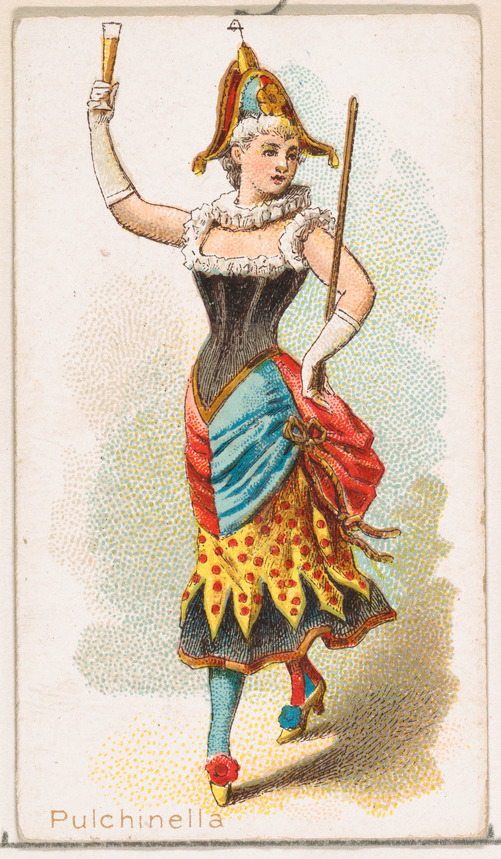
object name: print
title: Pulchinella Dancer, from the Dancing Women series (N186) issued by Wm. S. Kimball & Co.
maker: william s. kimball & company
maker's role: publisher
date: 1889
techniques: color lithograph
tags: women,dancing,dancers